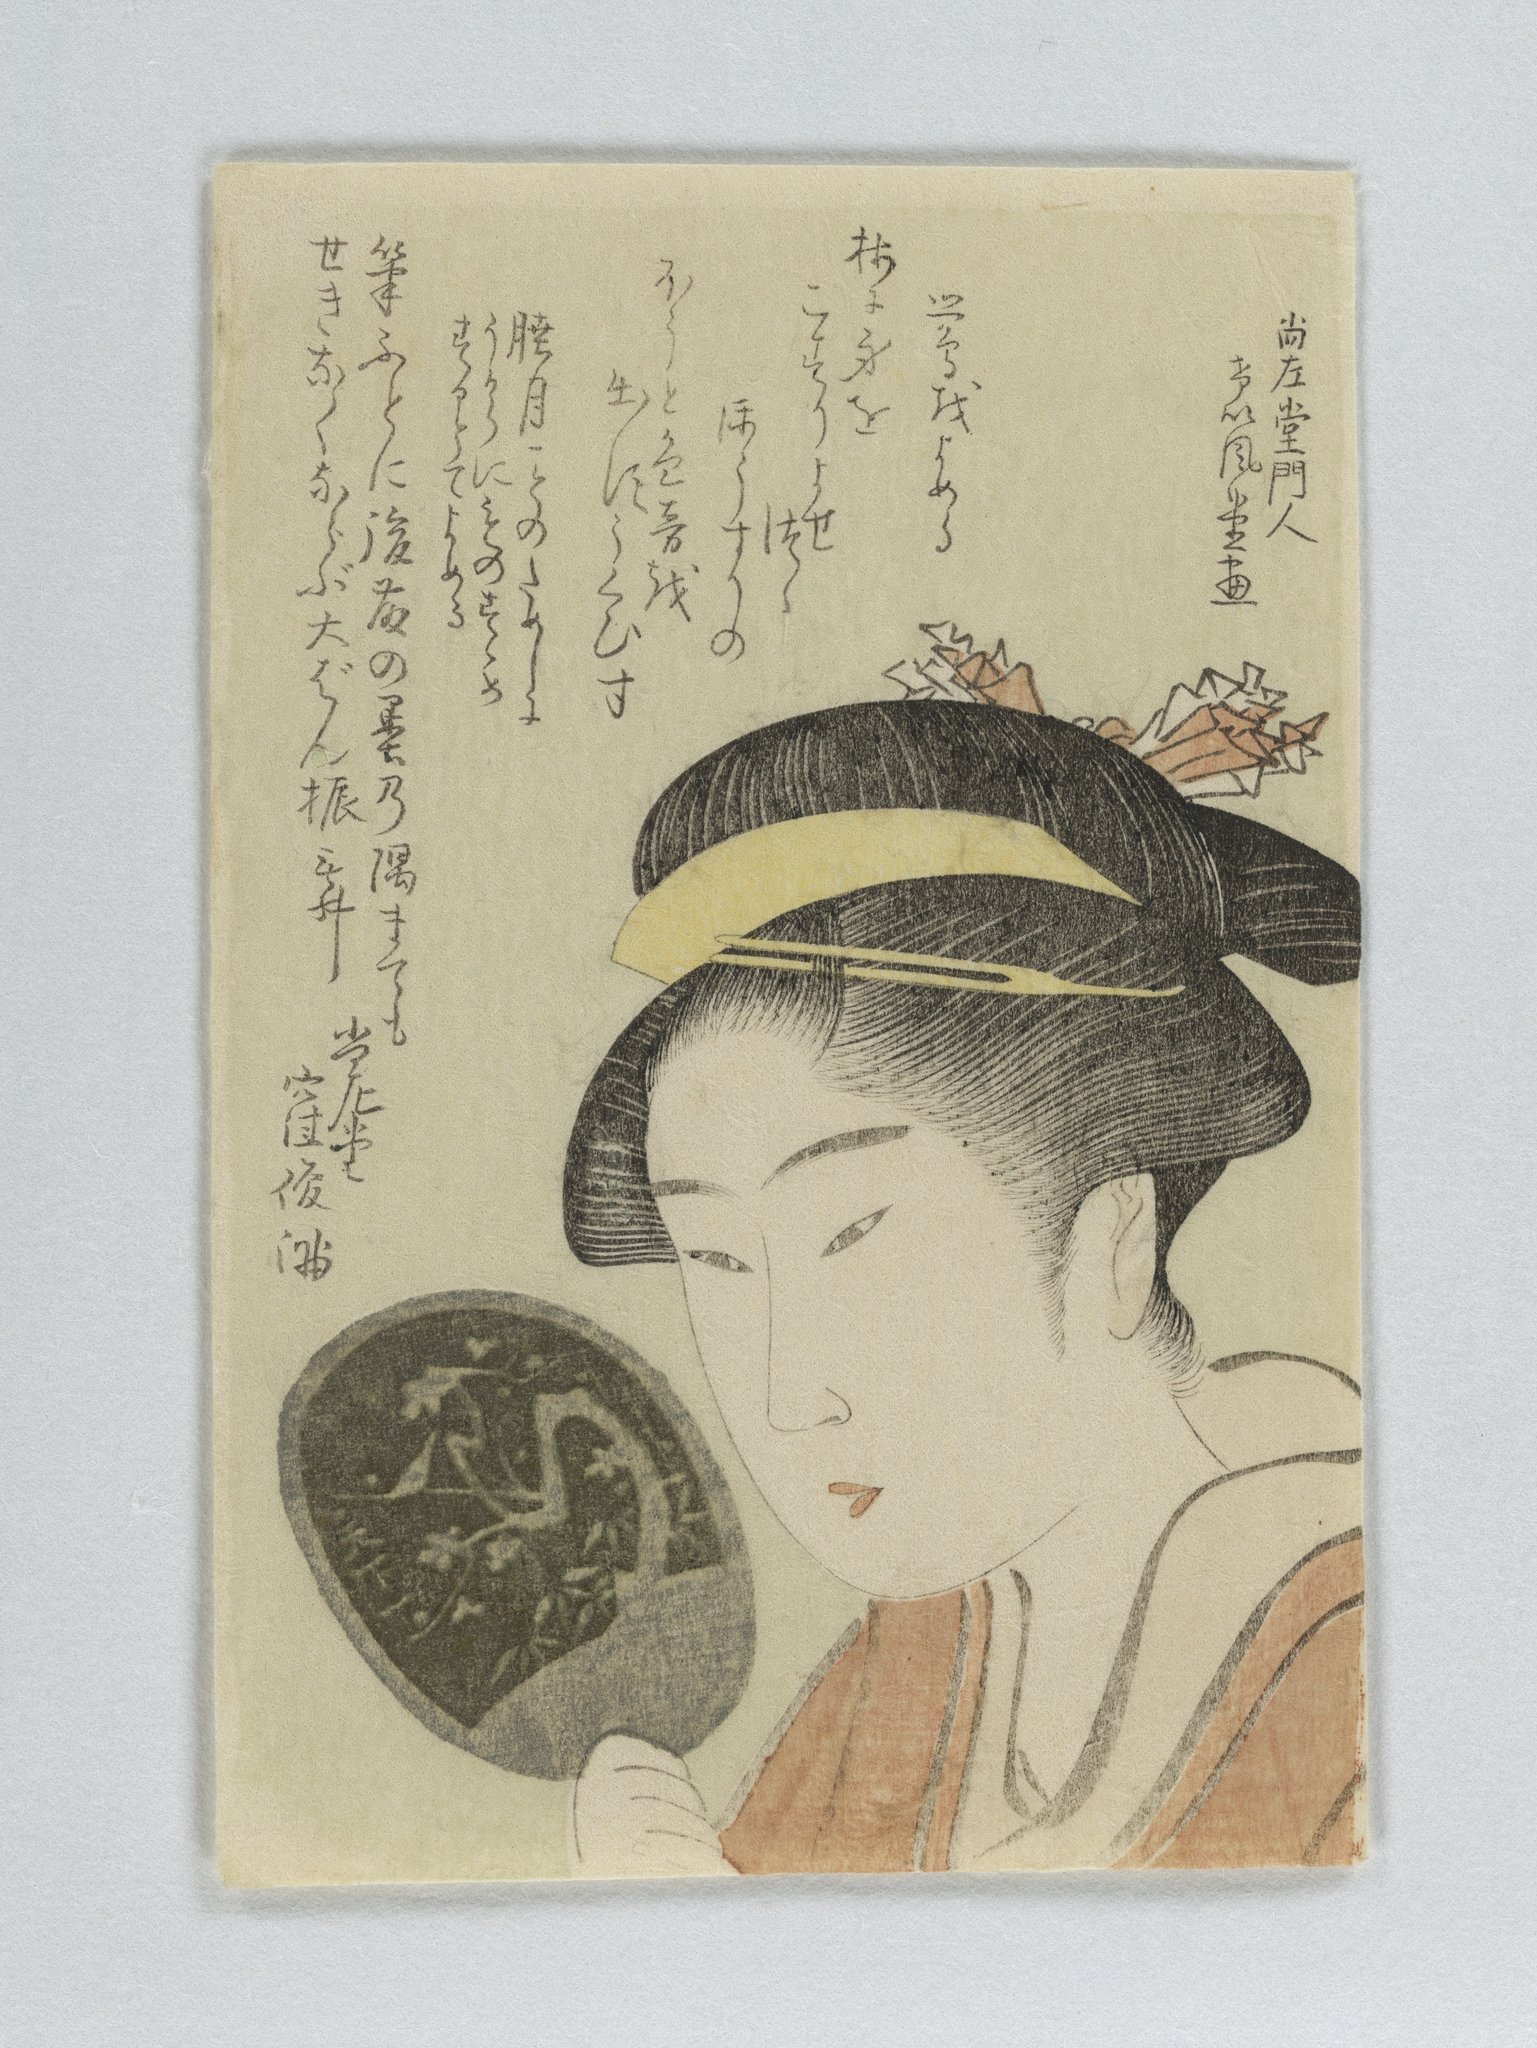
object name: woodblock print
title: Bust Portrait of Woman with Mirror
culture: japanese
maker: kubo shunman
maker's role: artist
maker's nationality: japanese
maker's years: 1757-1820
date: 1796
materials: ink, paper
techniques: surimono, woodblock print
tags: portraits,women,mirrors